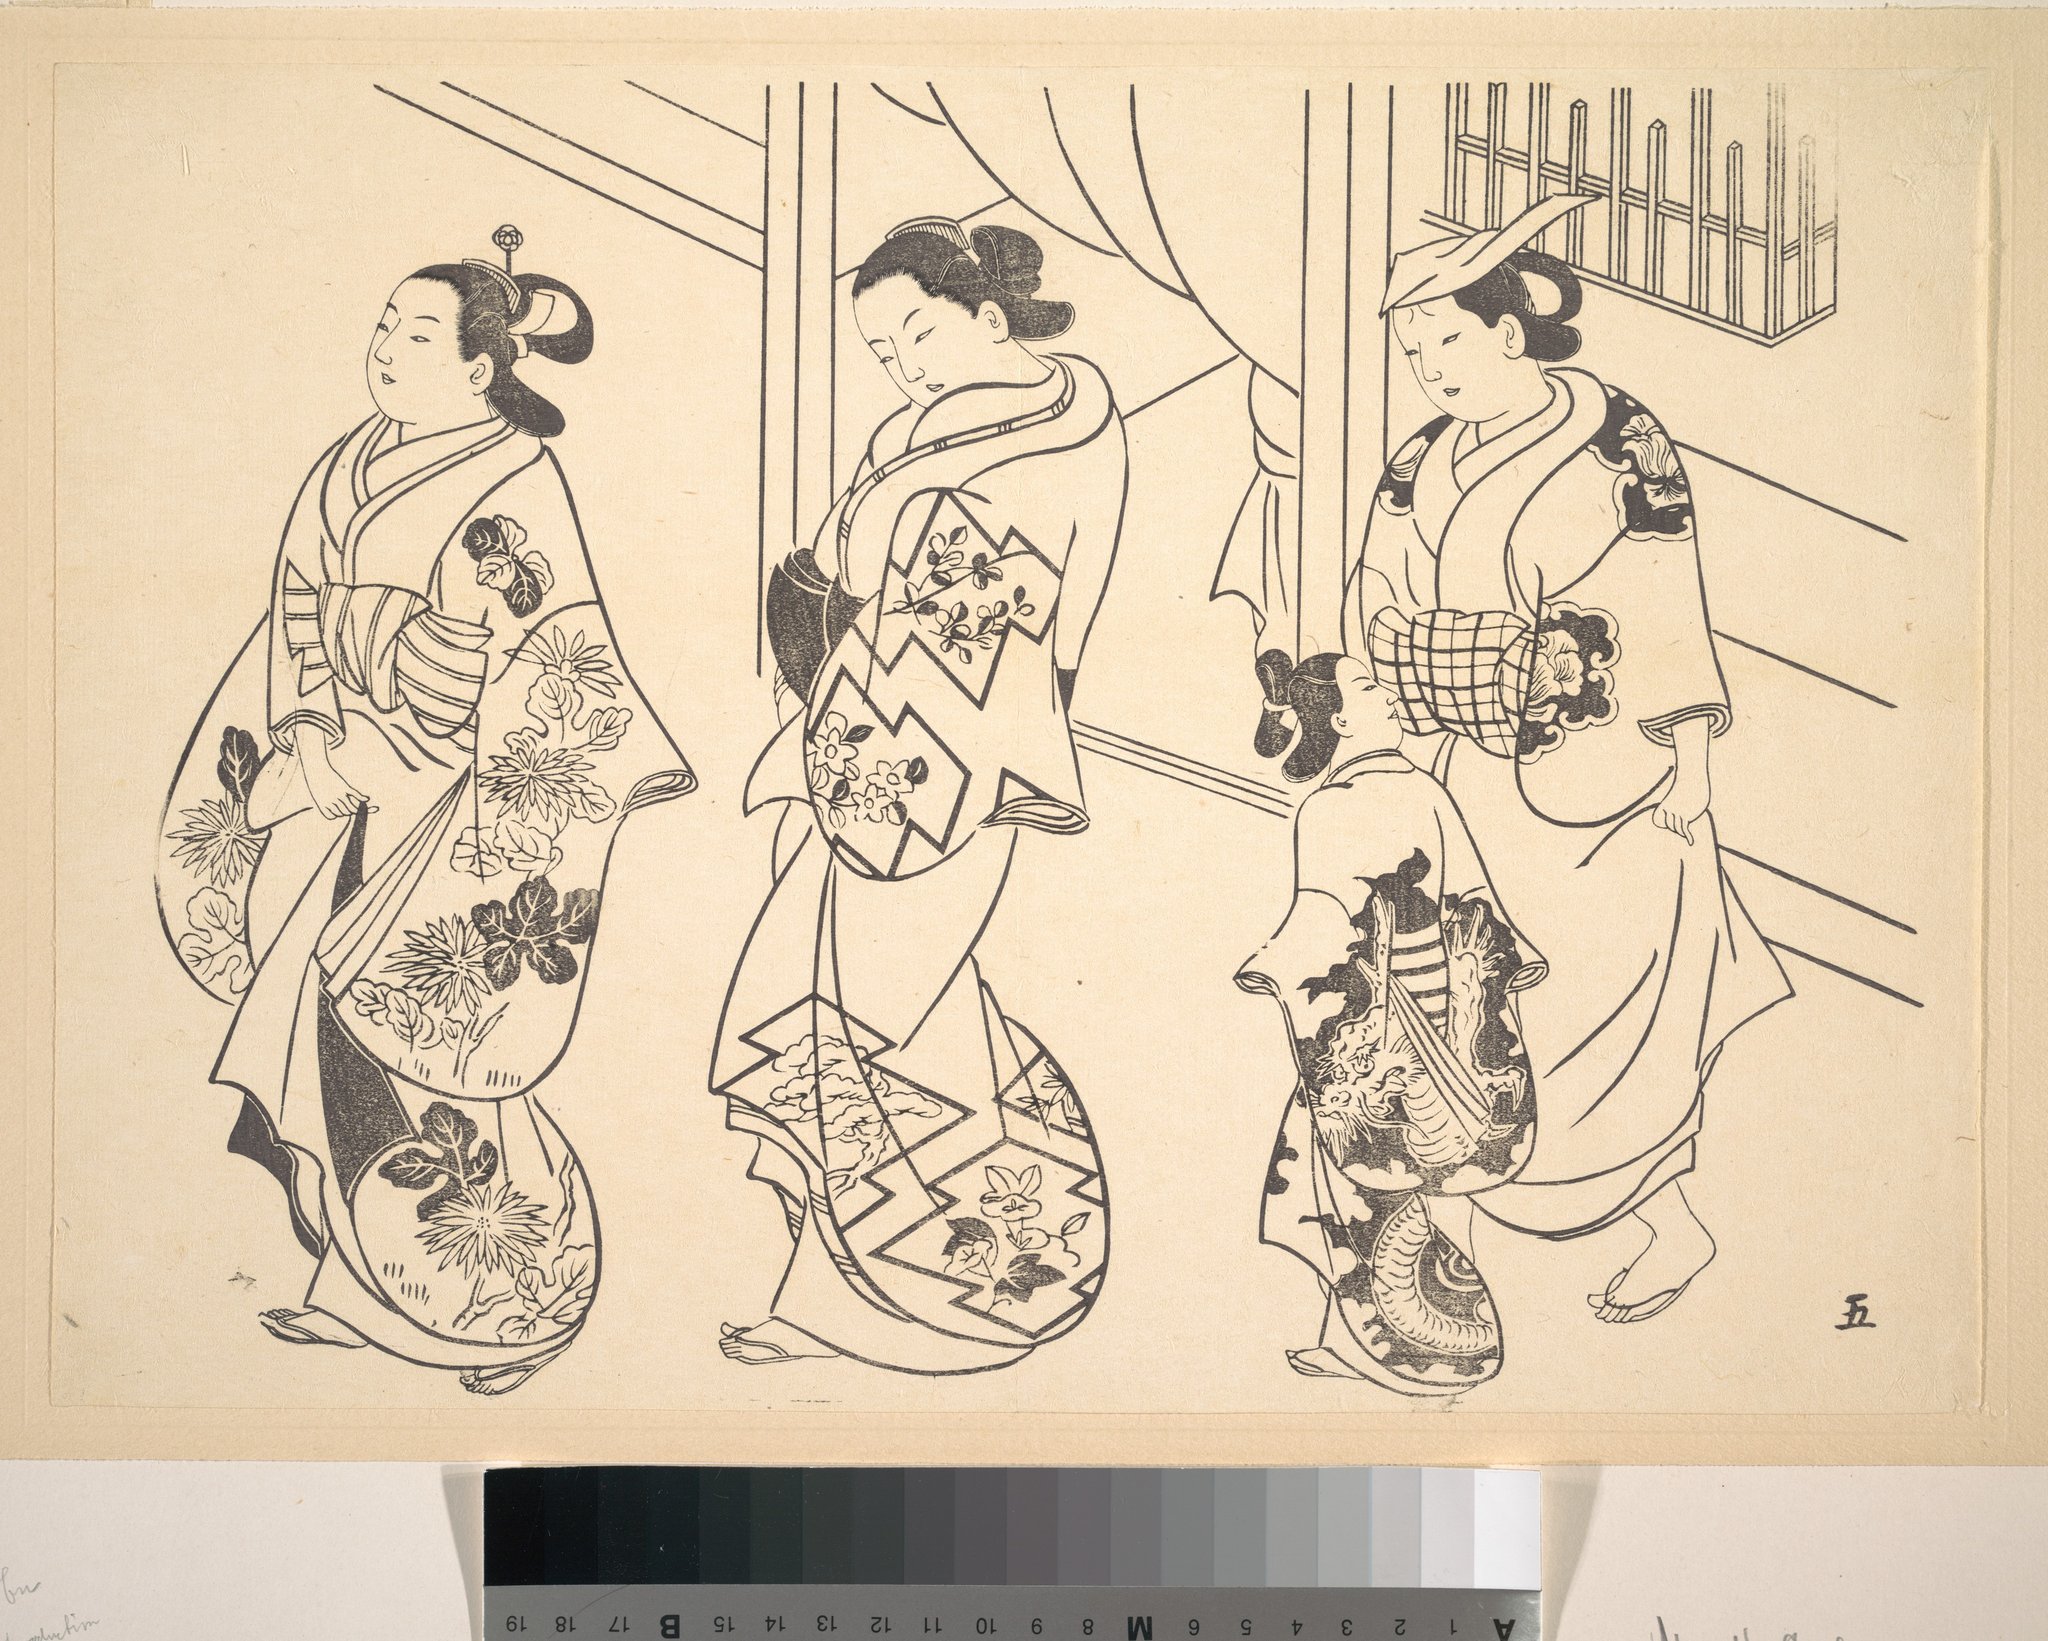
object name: print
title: Three Courtesans and a Kamuro Strolling in the Street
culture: japanese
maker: okumura masanobu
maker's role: artist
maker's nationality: japanese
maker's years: 1686-1764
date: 1868-1912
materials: ink, paper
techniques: woodblock print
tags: girls,women